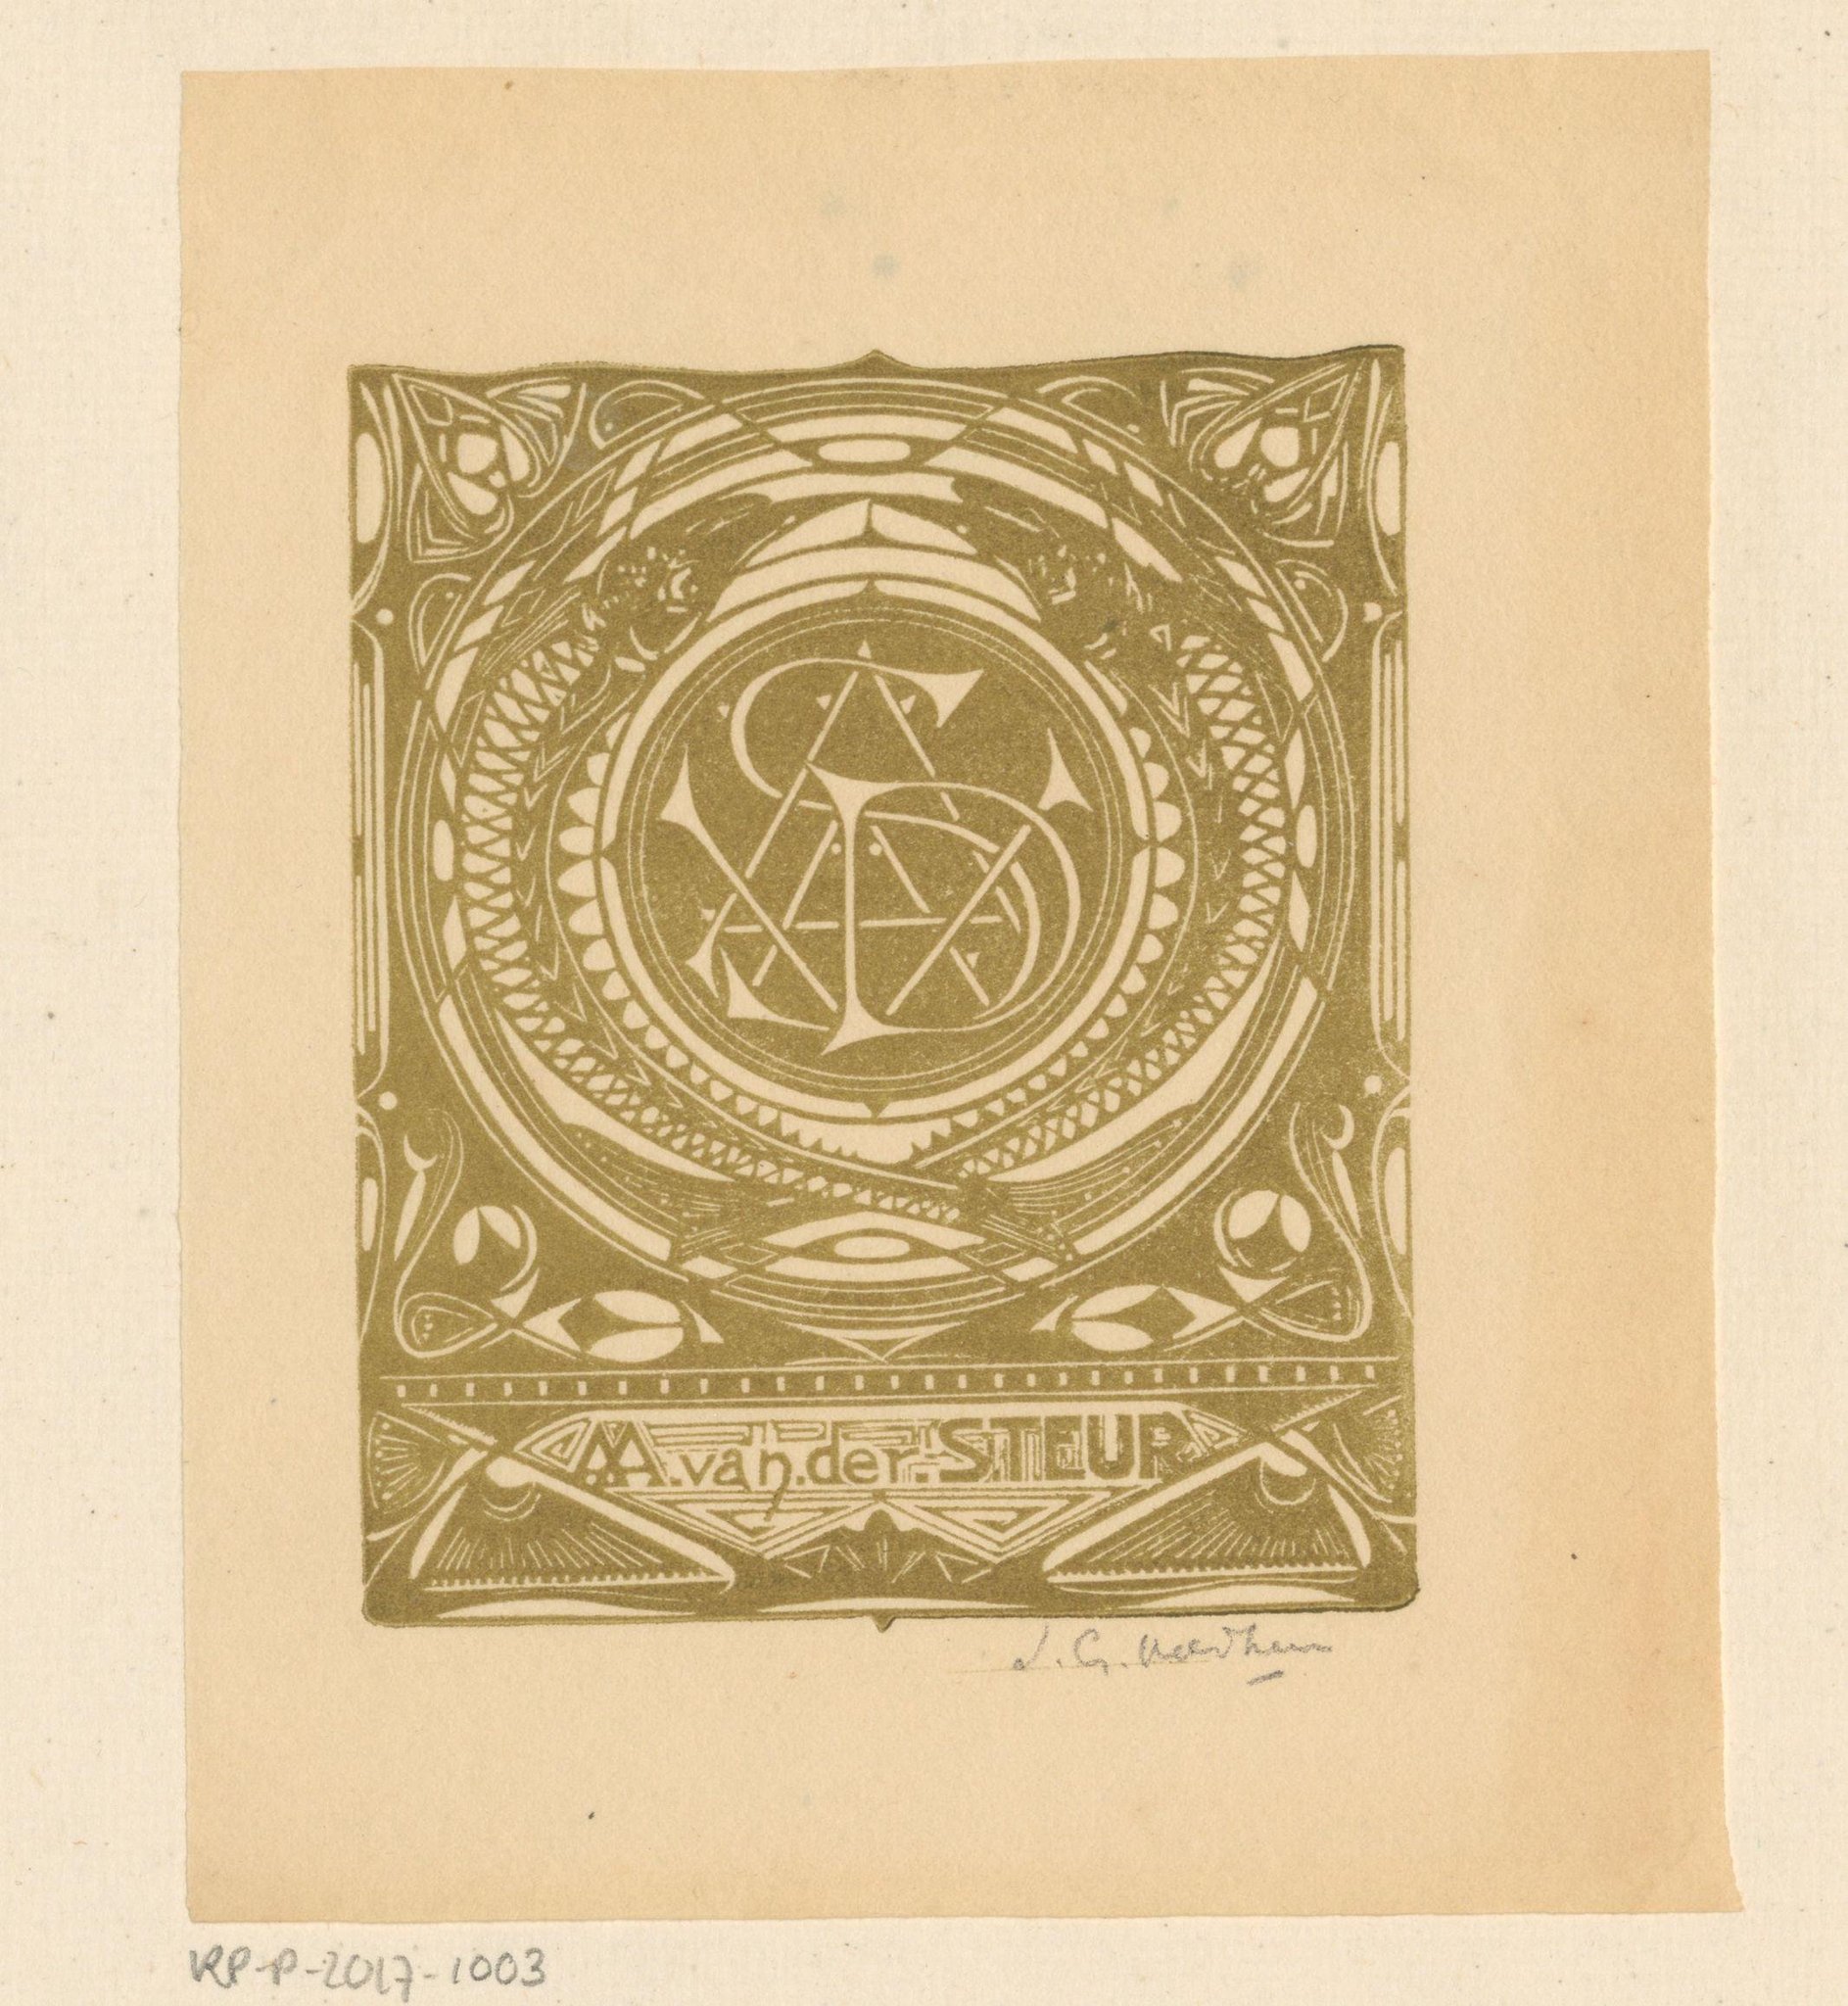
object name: bookplate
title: Ex libris van A.A. van der Steur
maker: jacobus gerardus veldheer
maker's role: draughtsman, print maker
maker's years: 1866-1954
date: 1876-1954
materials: paper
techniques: engraving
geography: netherlands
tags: fishes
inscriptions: signature: ‘J.G. Veldheer’